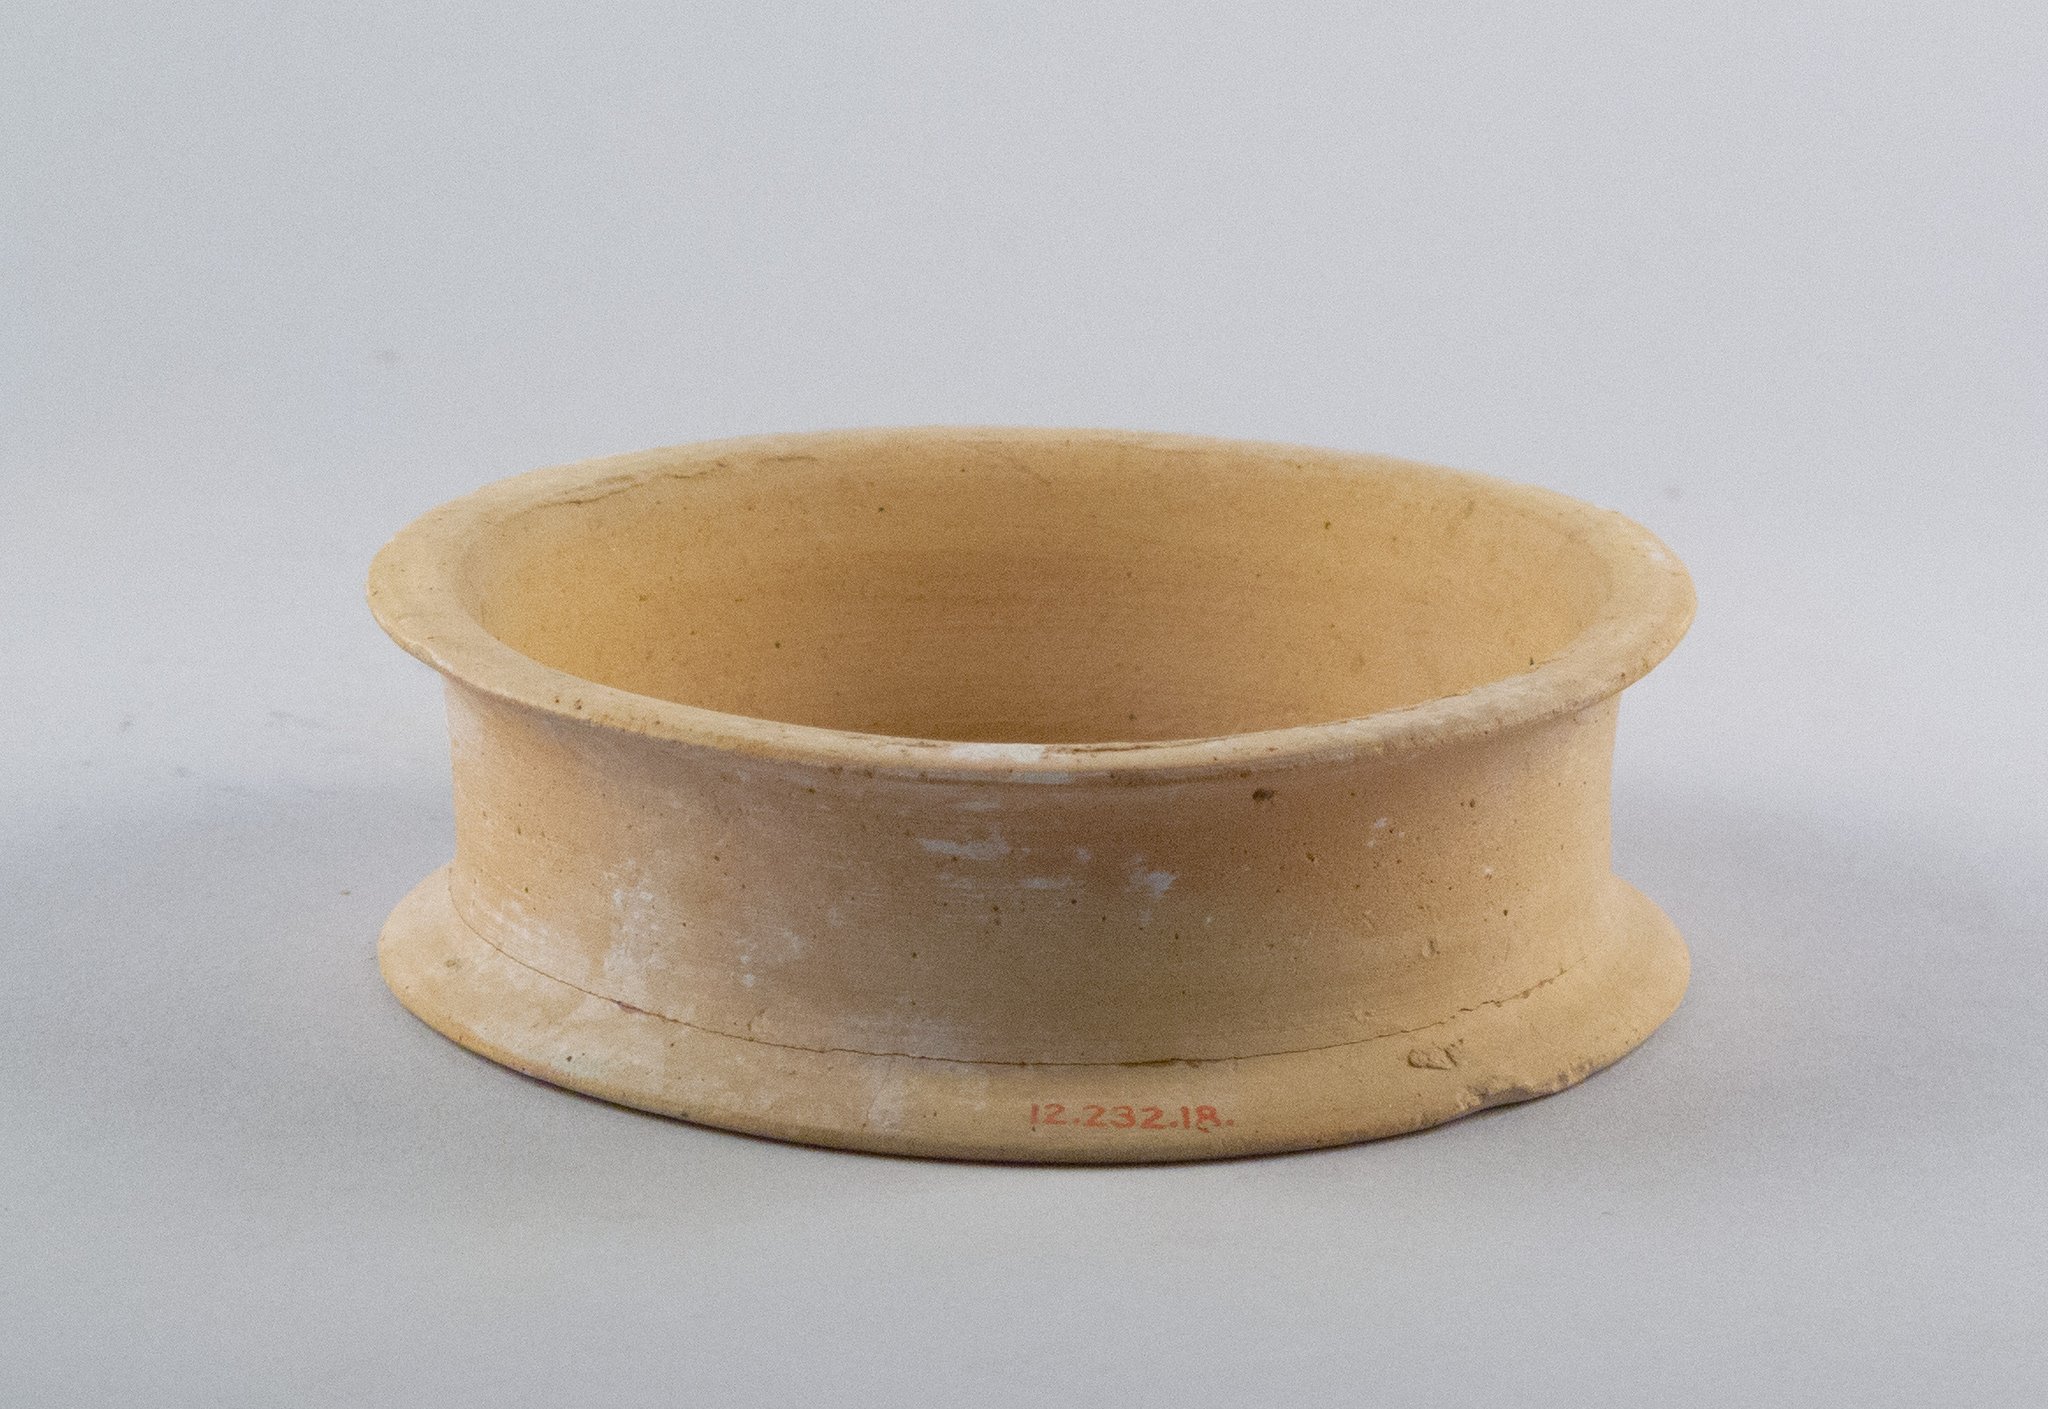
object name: statue base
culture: greek or south italian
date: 7000-30 BCE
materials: terracotta